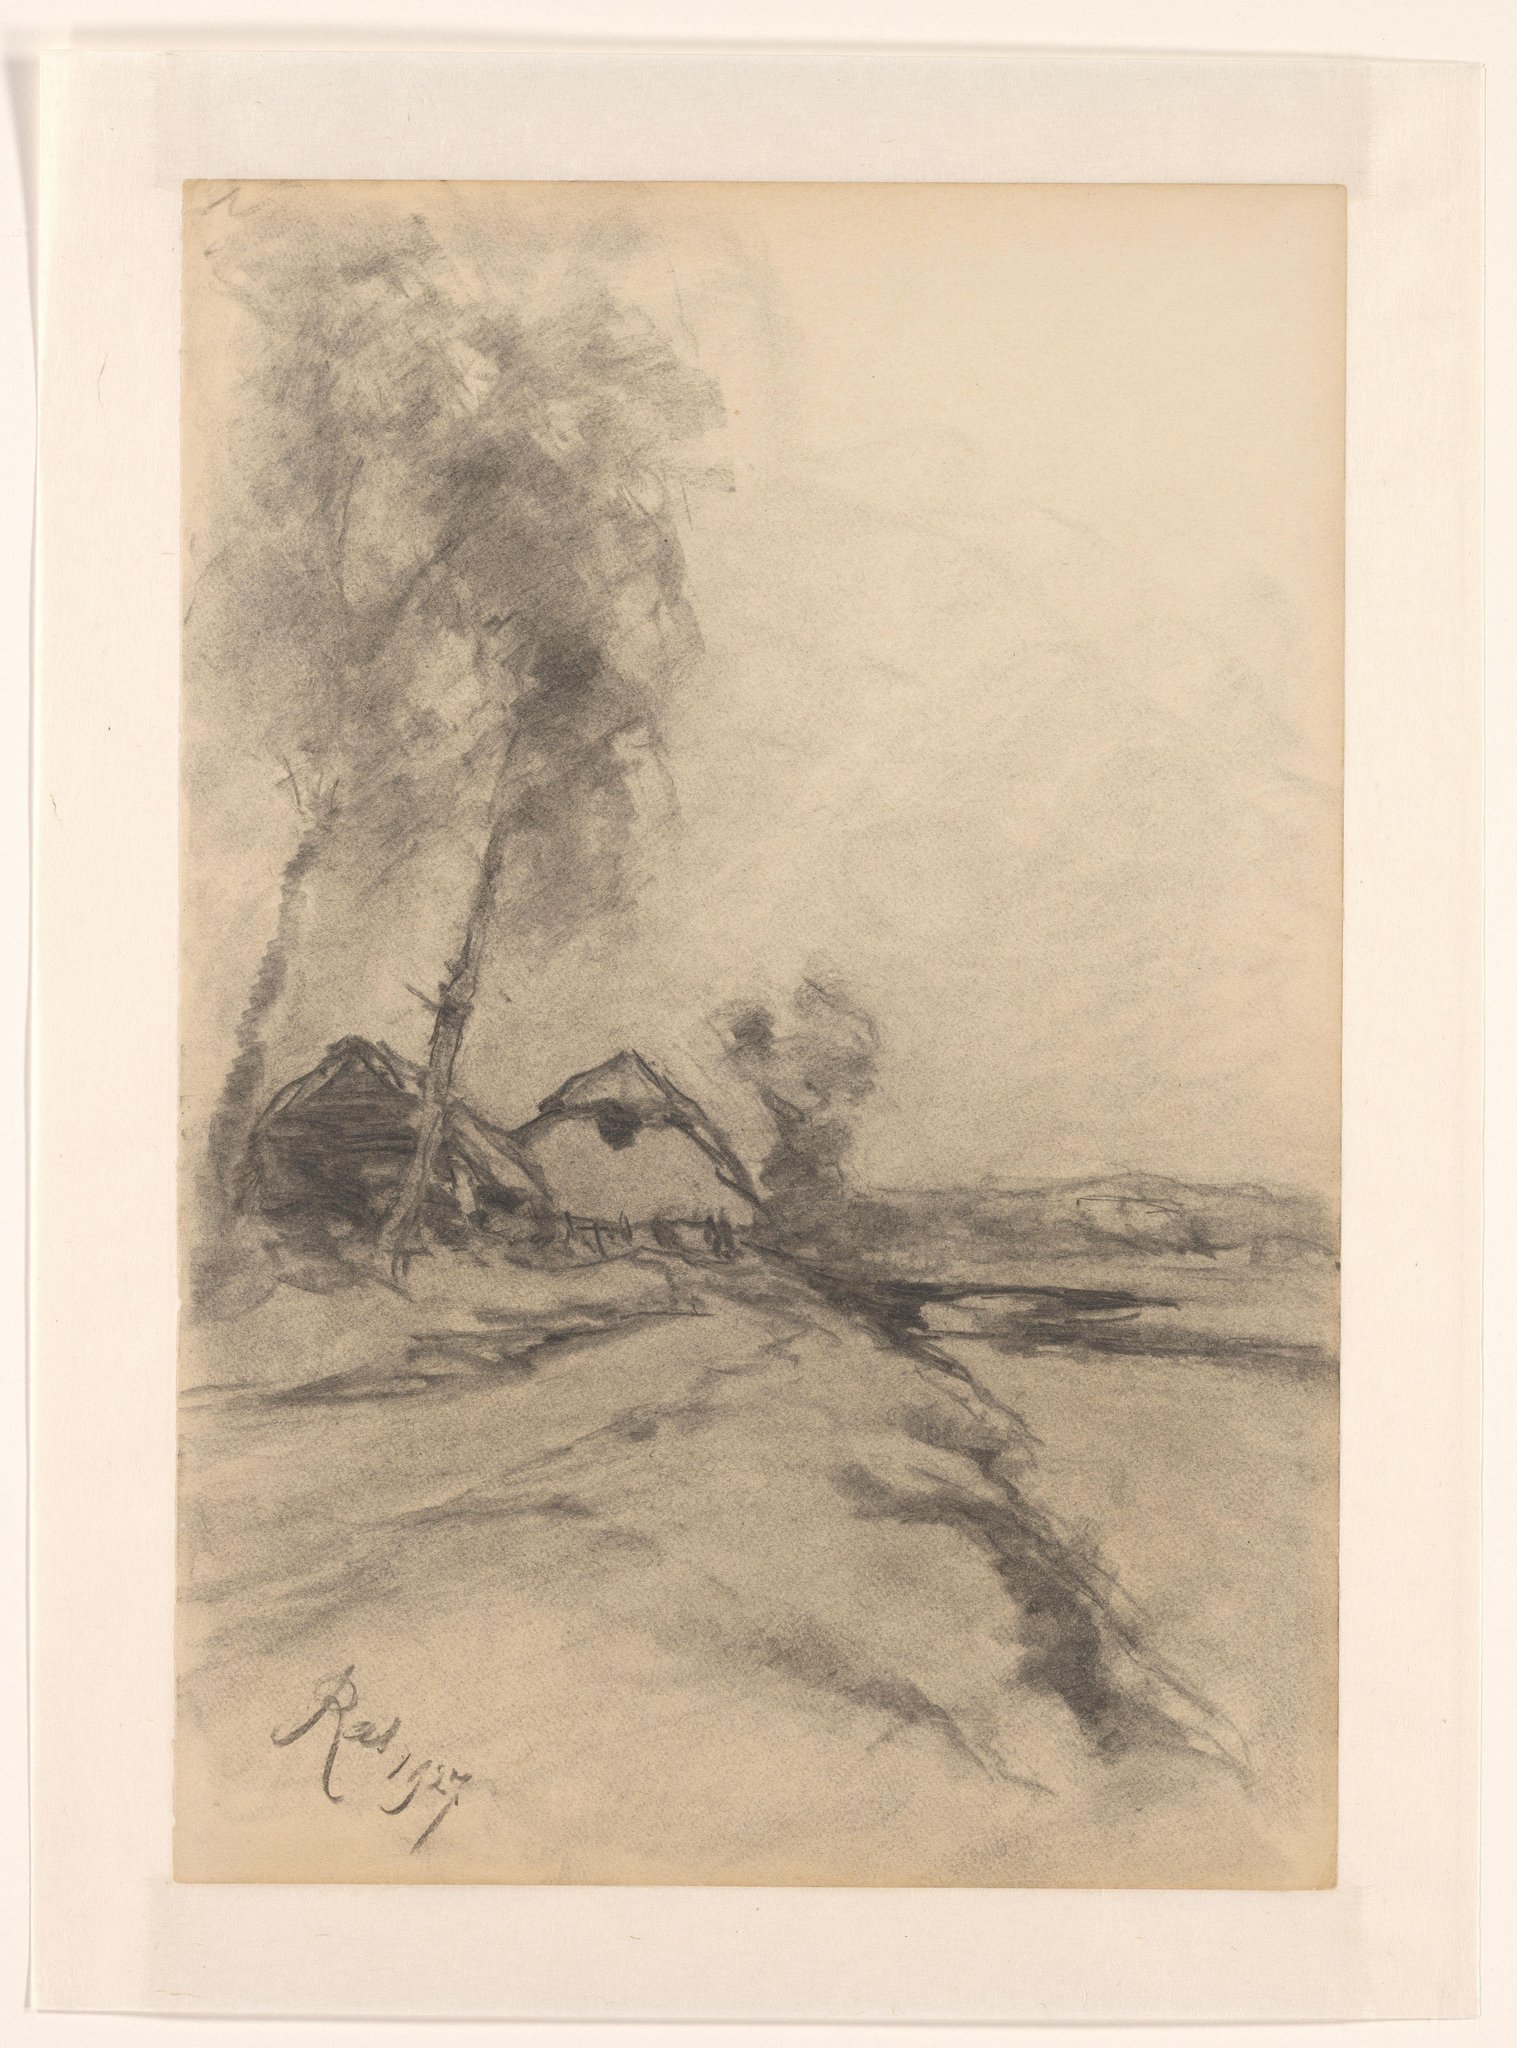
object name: drawing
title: Boerderij aan een vaart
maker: pieter h.j.j. ras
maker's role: draughtsman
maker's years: 1857-1941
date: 1927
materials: chalk, paper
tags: farm or solitary house in landscape, farm (building)